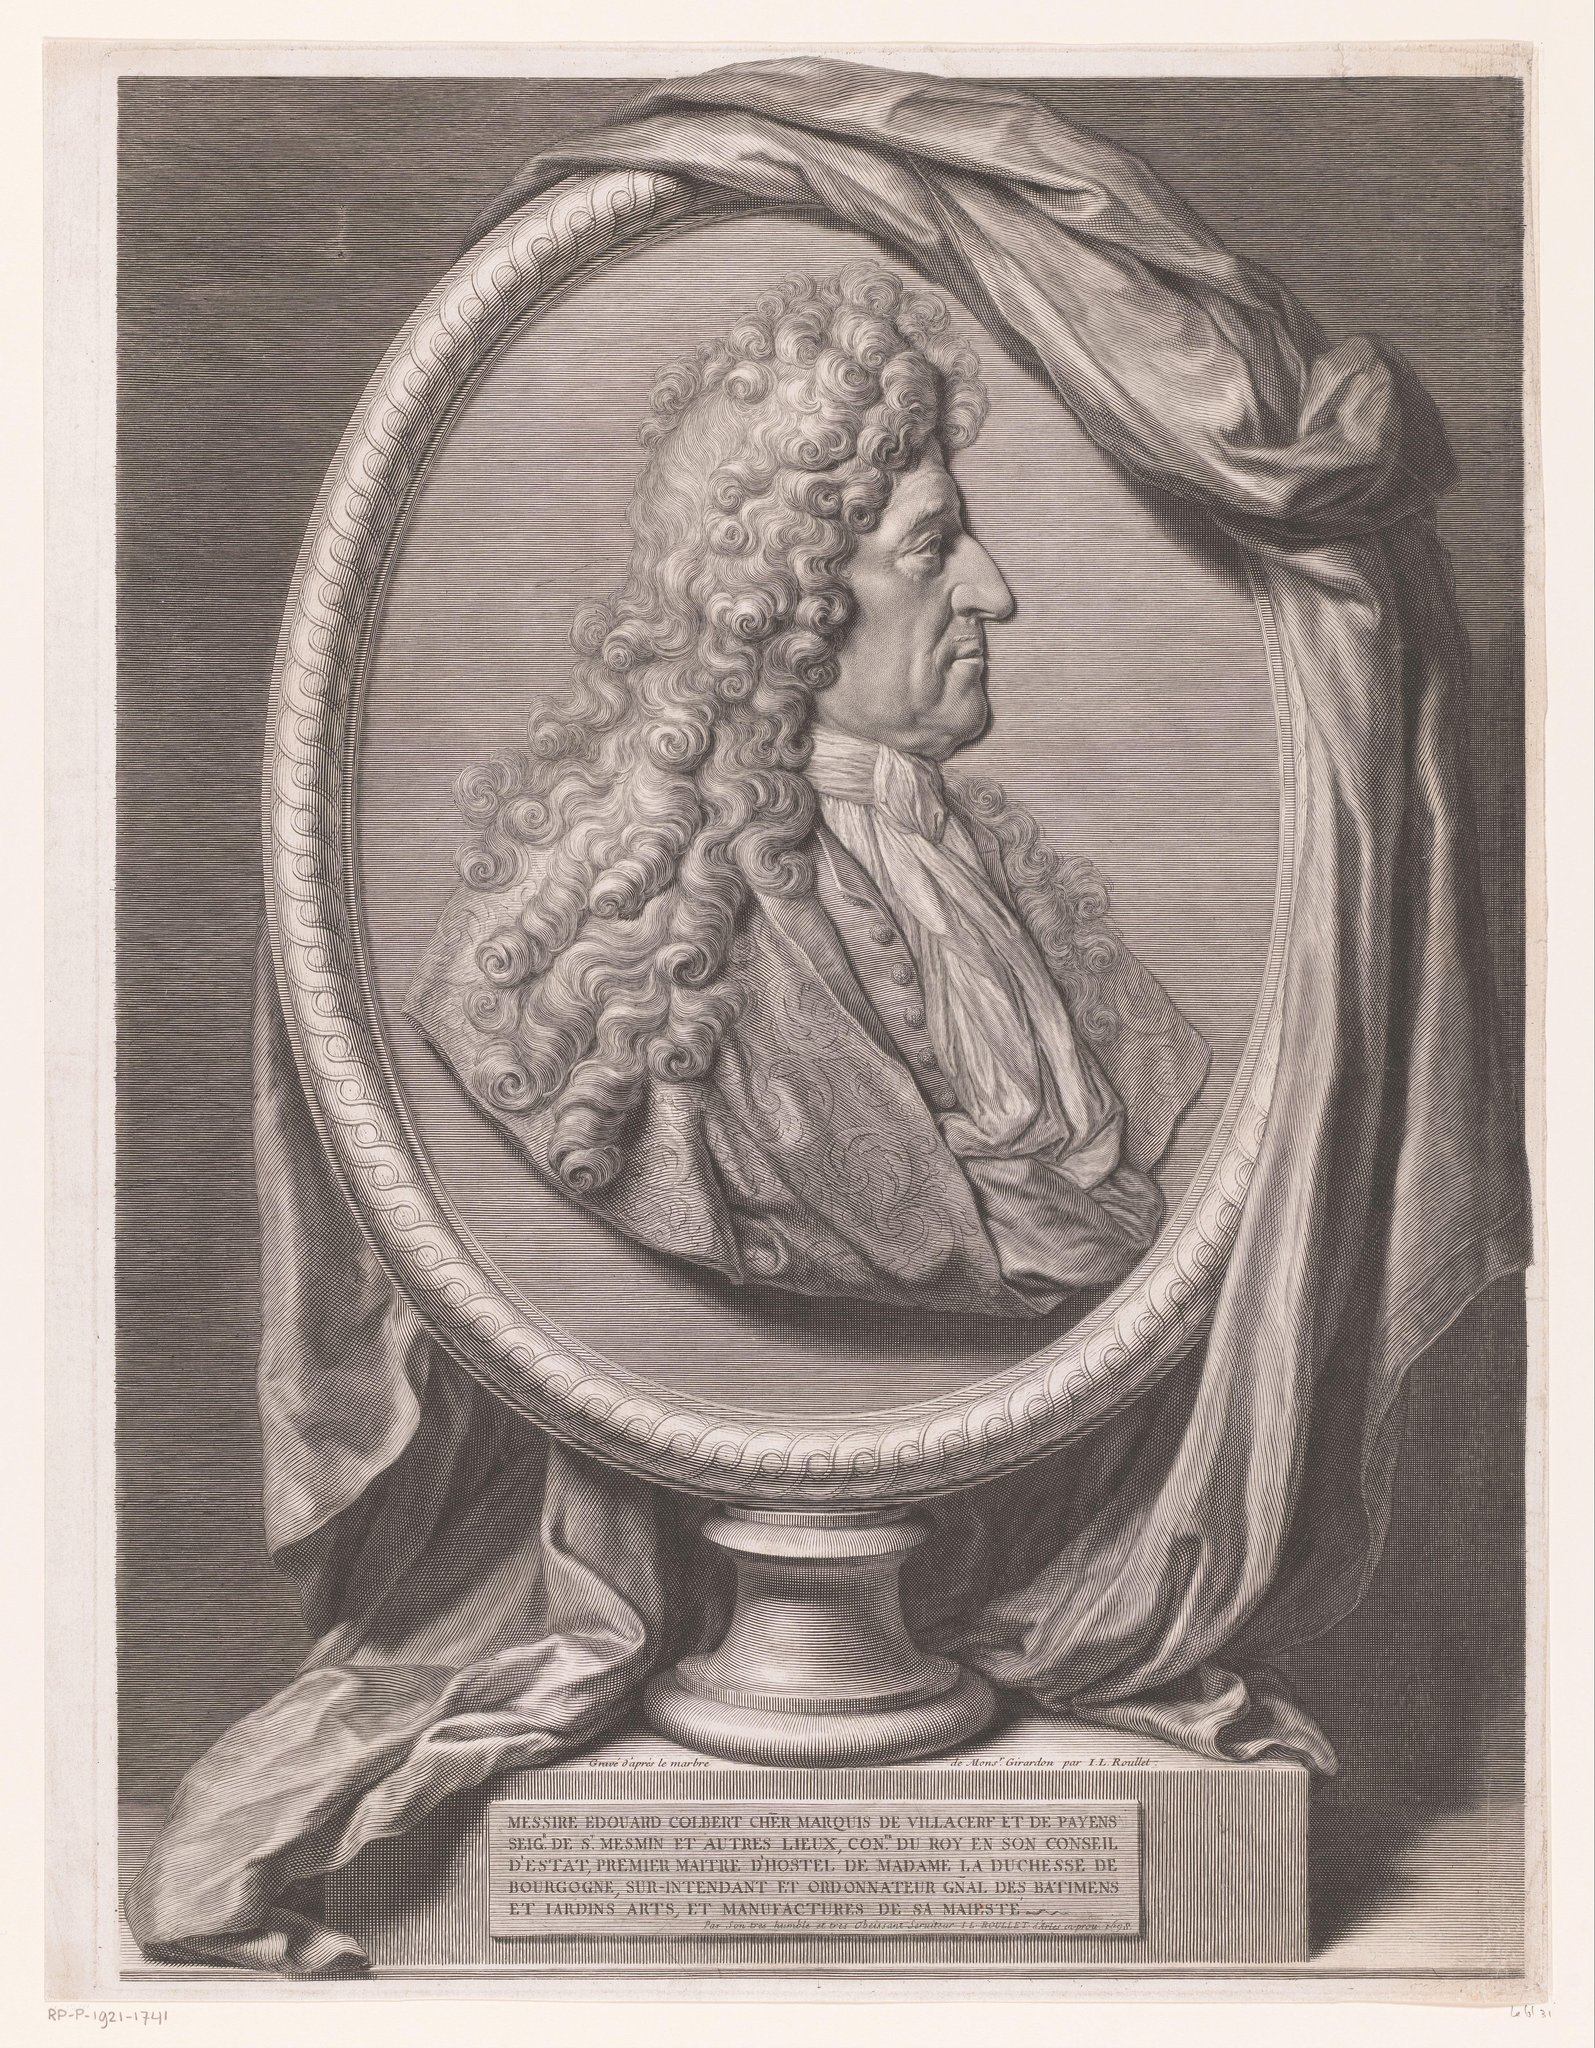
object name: print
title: Portret van Edouard Colbert de Villacerf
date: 1698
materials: paper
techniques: engraving, etching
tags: france, paris, edouard colbert de villacerf, official; civil servant; functionary (in general), historical persons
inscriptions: collector's mark: Lugt 2233